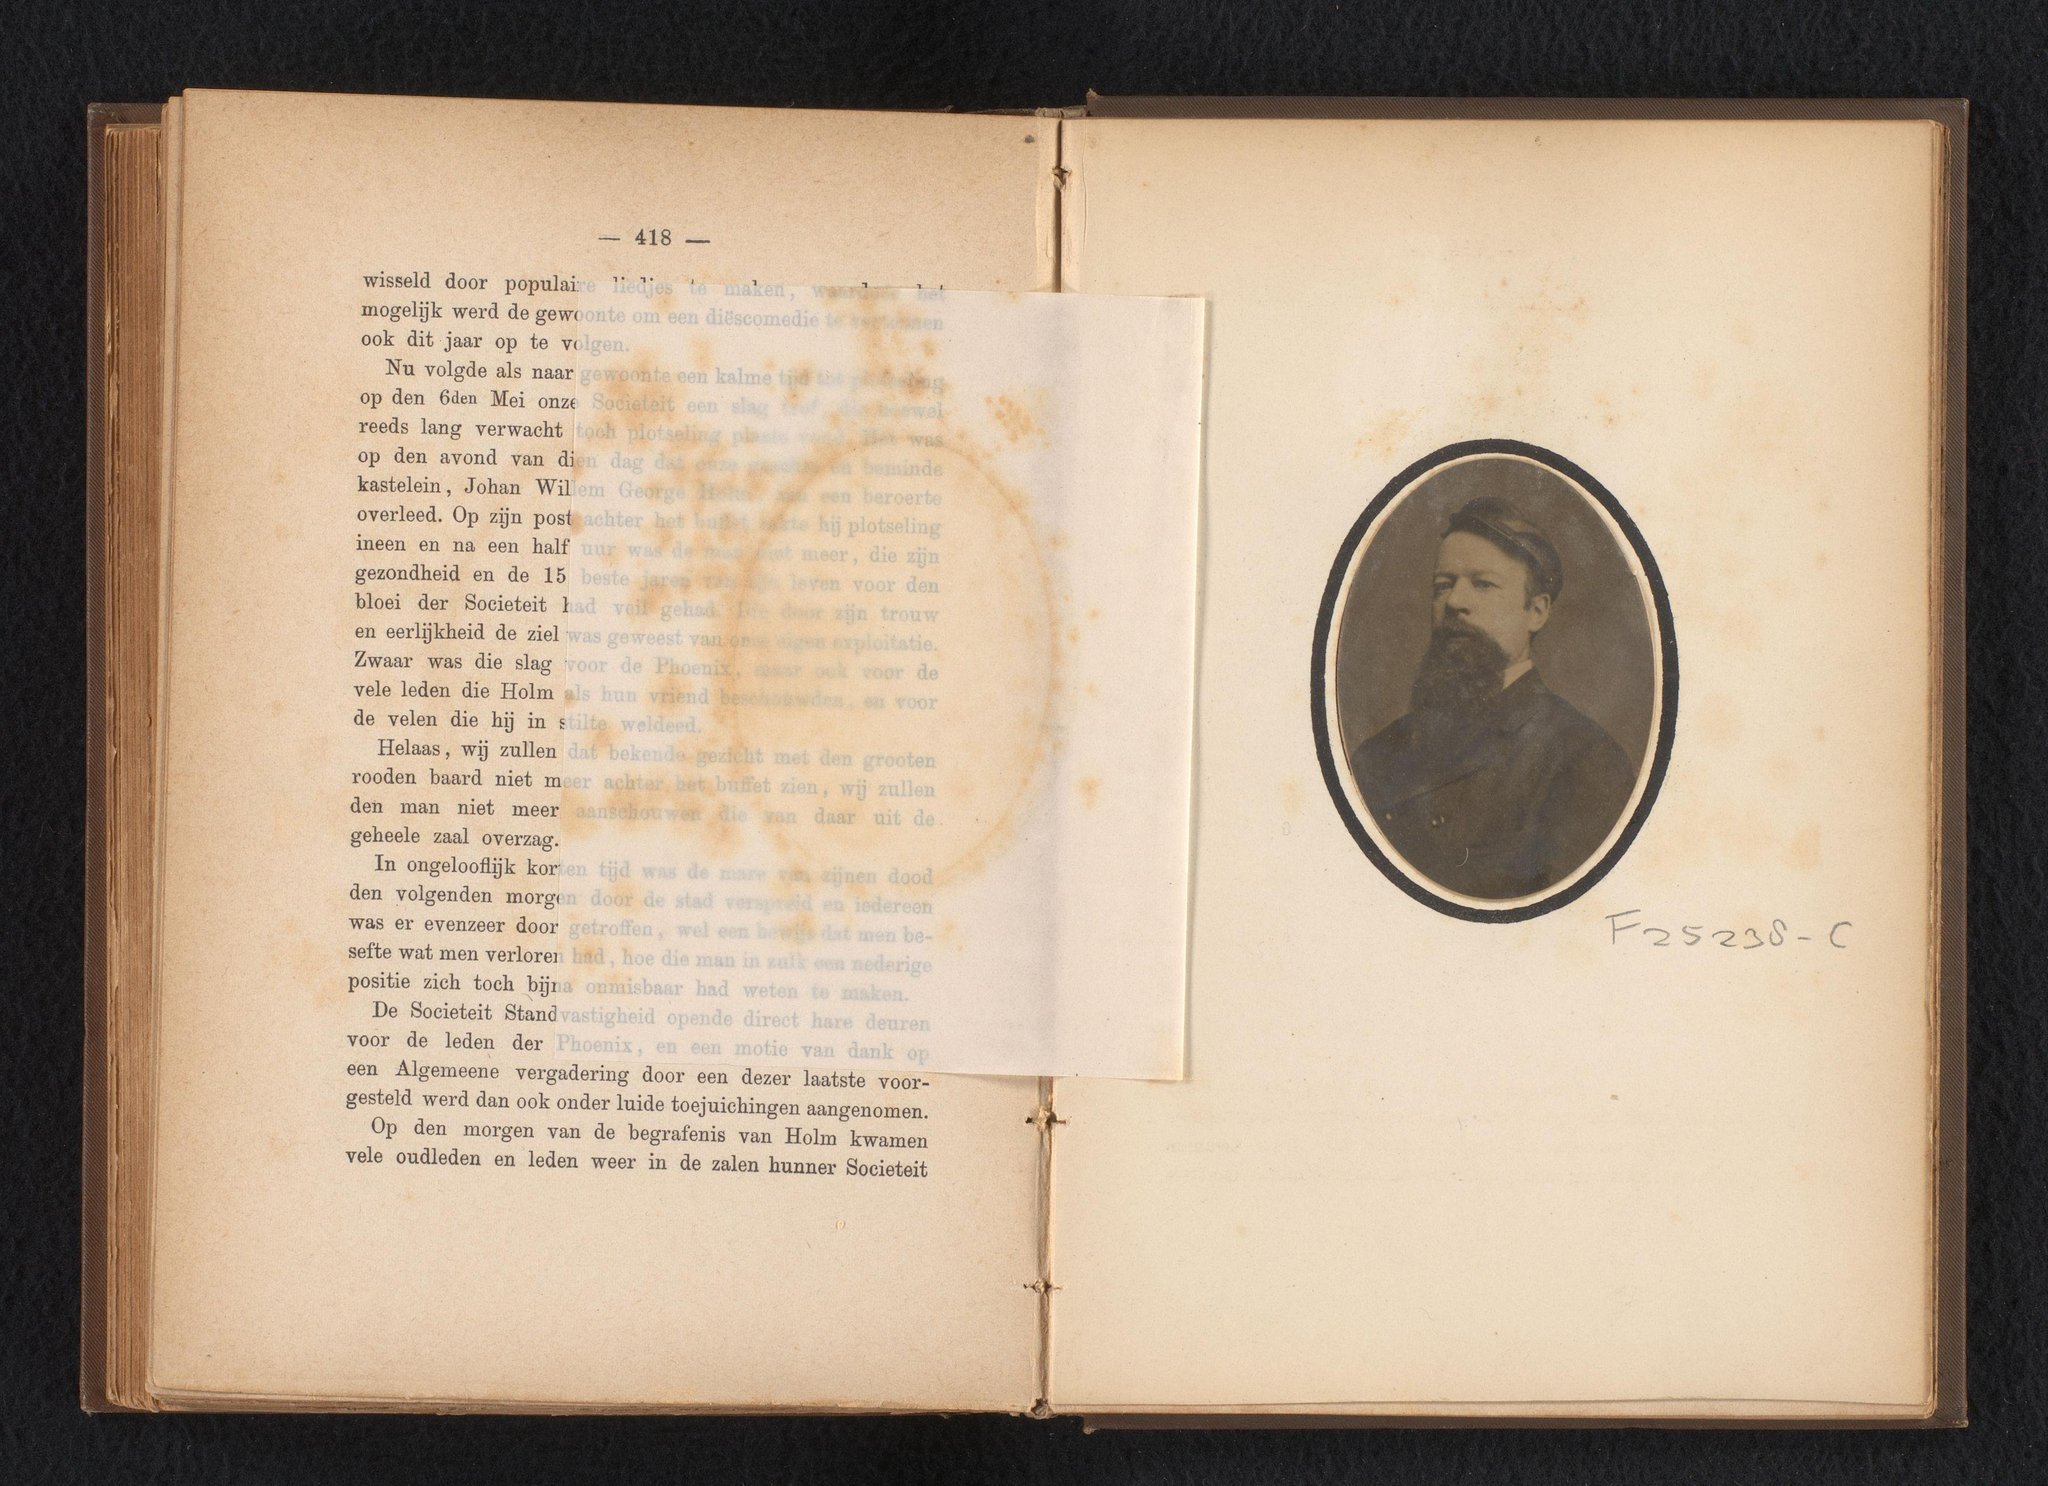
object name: photograph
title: Portret van J.W.G. Holm, kastelein van de Societeit Phoenix te Delft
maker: Anonymous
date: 1879-1884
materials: paper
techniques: albumen print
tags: delft, historical persons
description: Foto op ongenummerde pagina tegenover pagina 418.